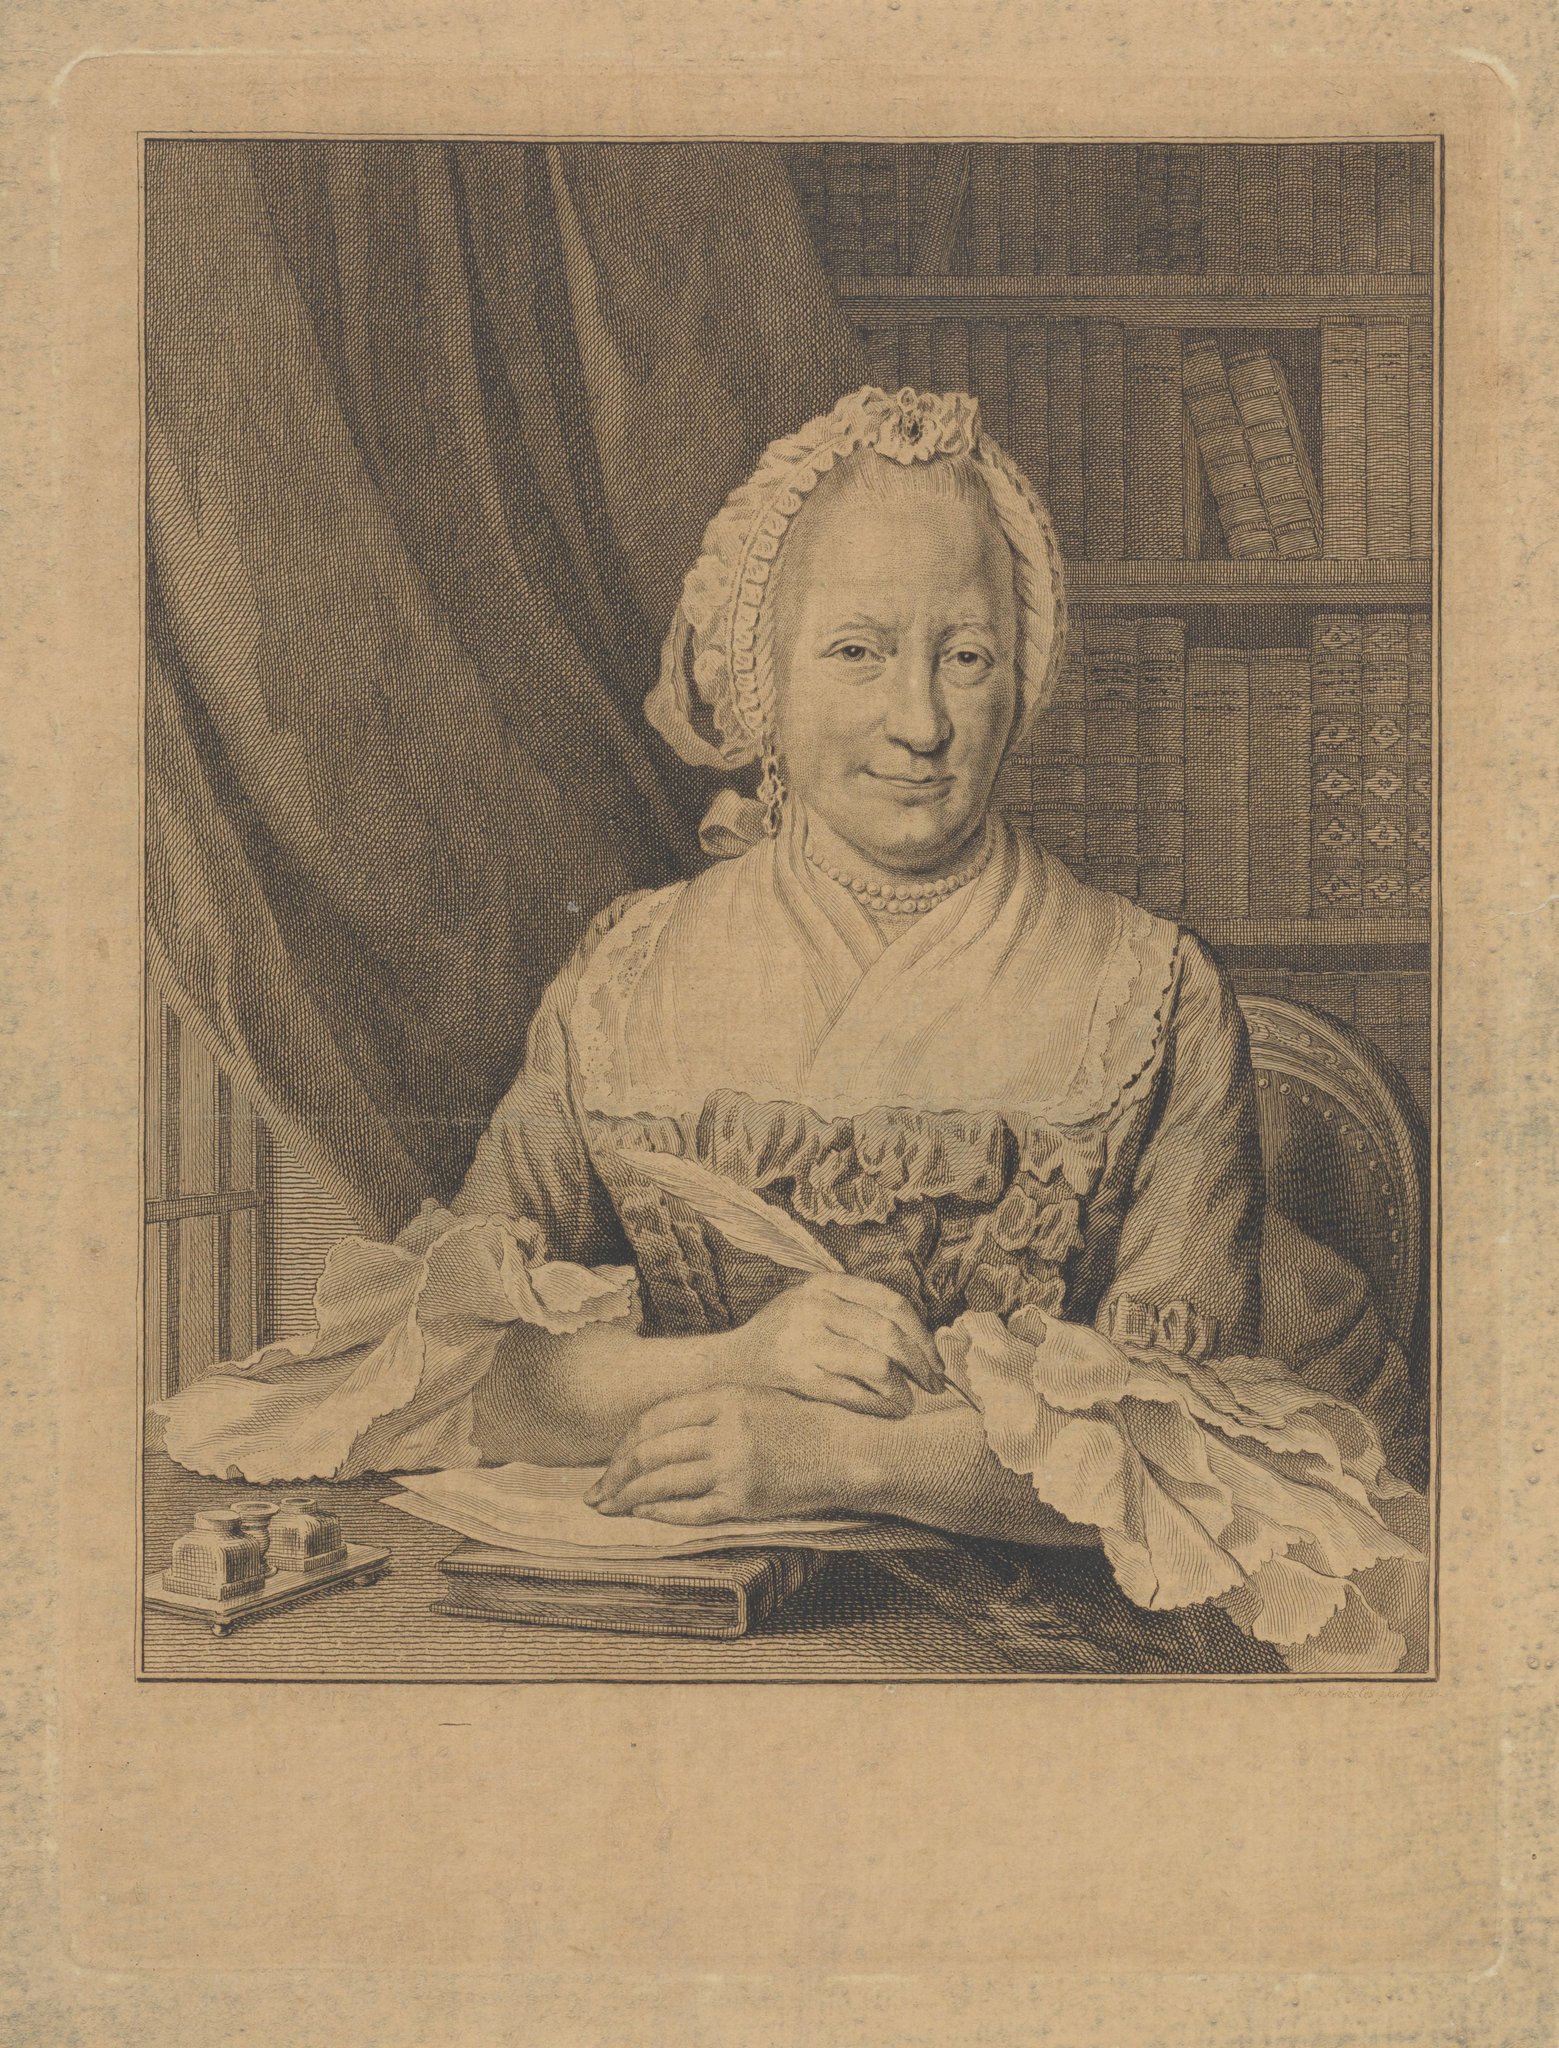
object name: print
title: Portret van Lucretia Wilhelmina van Merken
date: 1792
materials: paper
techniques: engraving, etching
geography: amsterdam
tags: amsterdam, lucretia wilhelmina van merken, quill, ink-well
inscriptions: collector's mark: Lugt 2228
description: Portret van de Nederlandse dichteres Lucretia Wilhelmina van Merken, zittend voor een tafel met voor haar inktpot, een boek en een vel papier, in haar hand een schrijfveer.